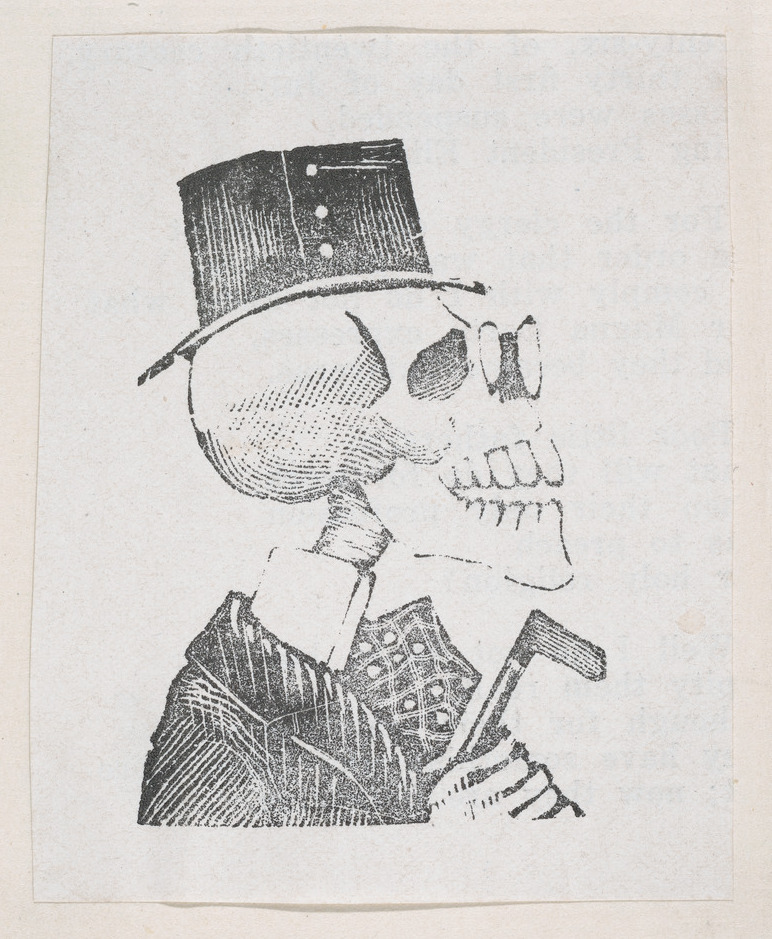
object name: print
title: A profile of a skeleton with a tophat, a coat, and glasses, from a broaside entitled 'La Calavera de Cupido', published by Antonio Vanegas Arroyo.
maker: josé guadalupe posada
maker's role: artist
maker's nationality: mexican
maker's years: 1852-1913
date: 1892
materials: metal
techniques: engraving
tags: skeletons